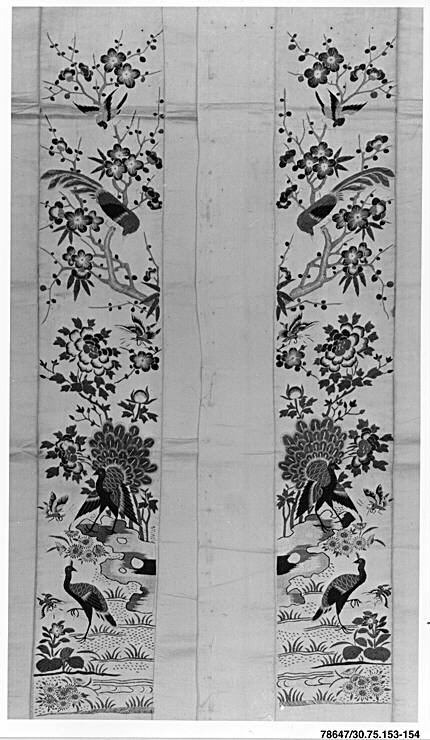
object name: sleeve band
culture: chinese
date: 1801-1900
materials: silk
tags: birds,peacocks,flowers,trees